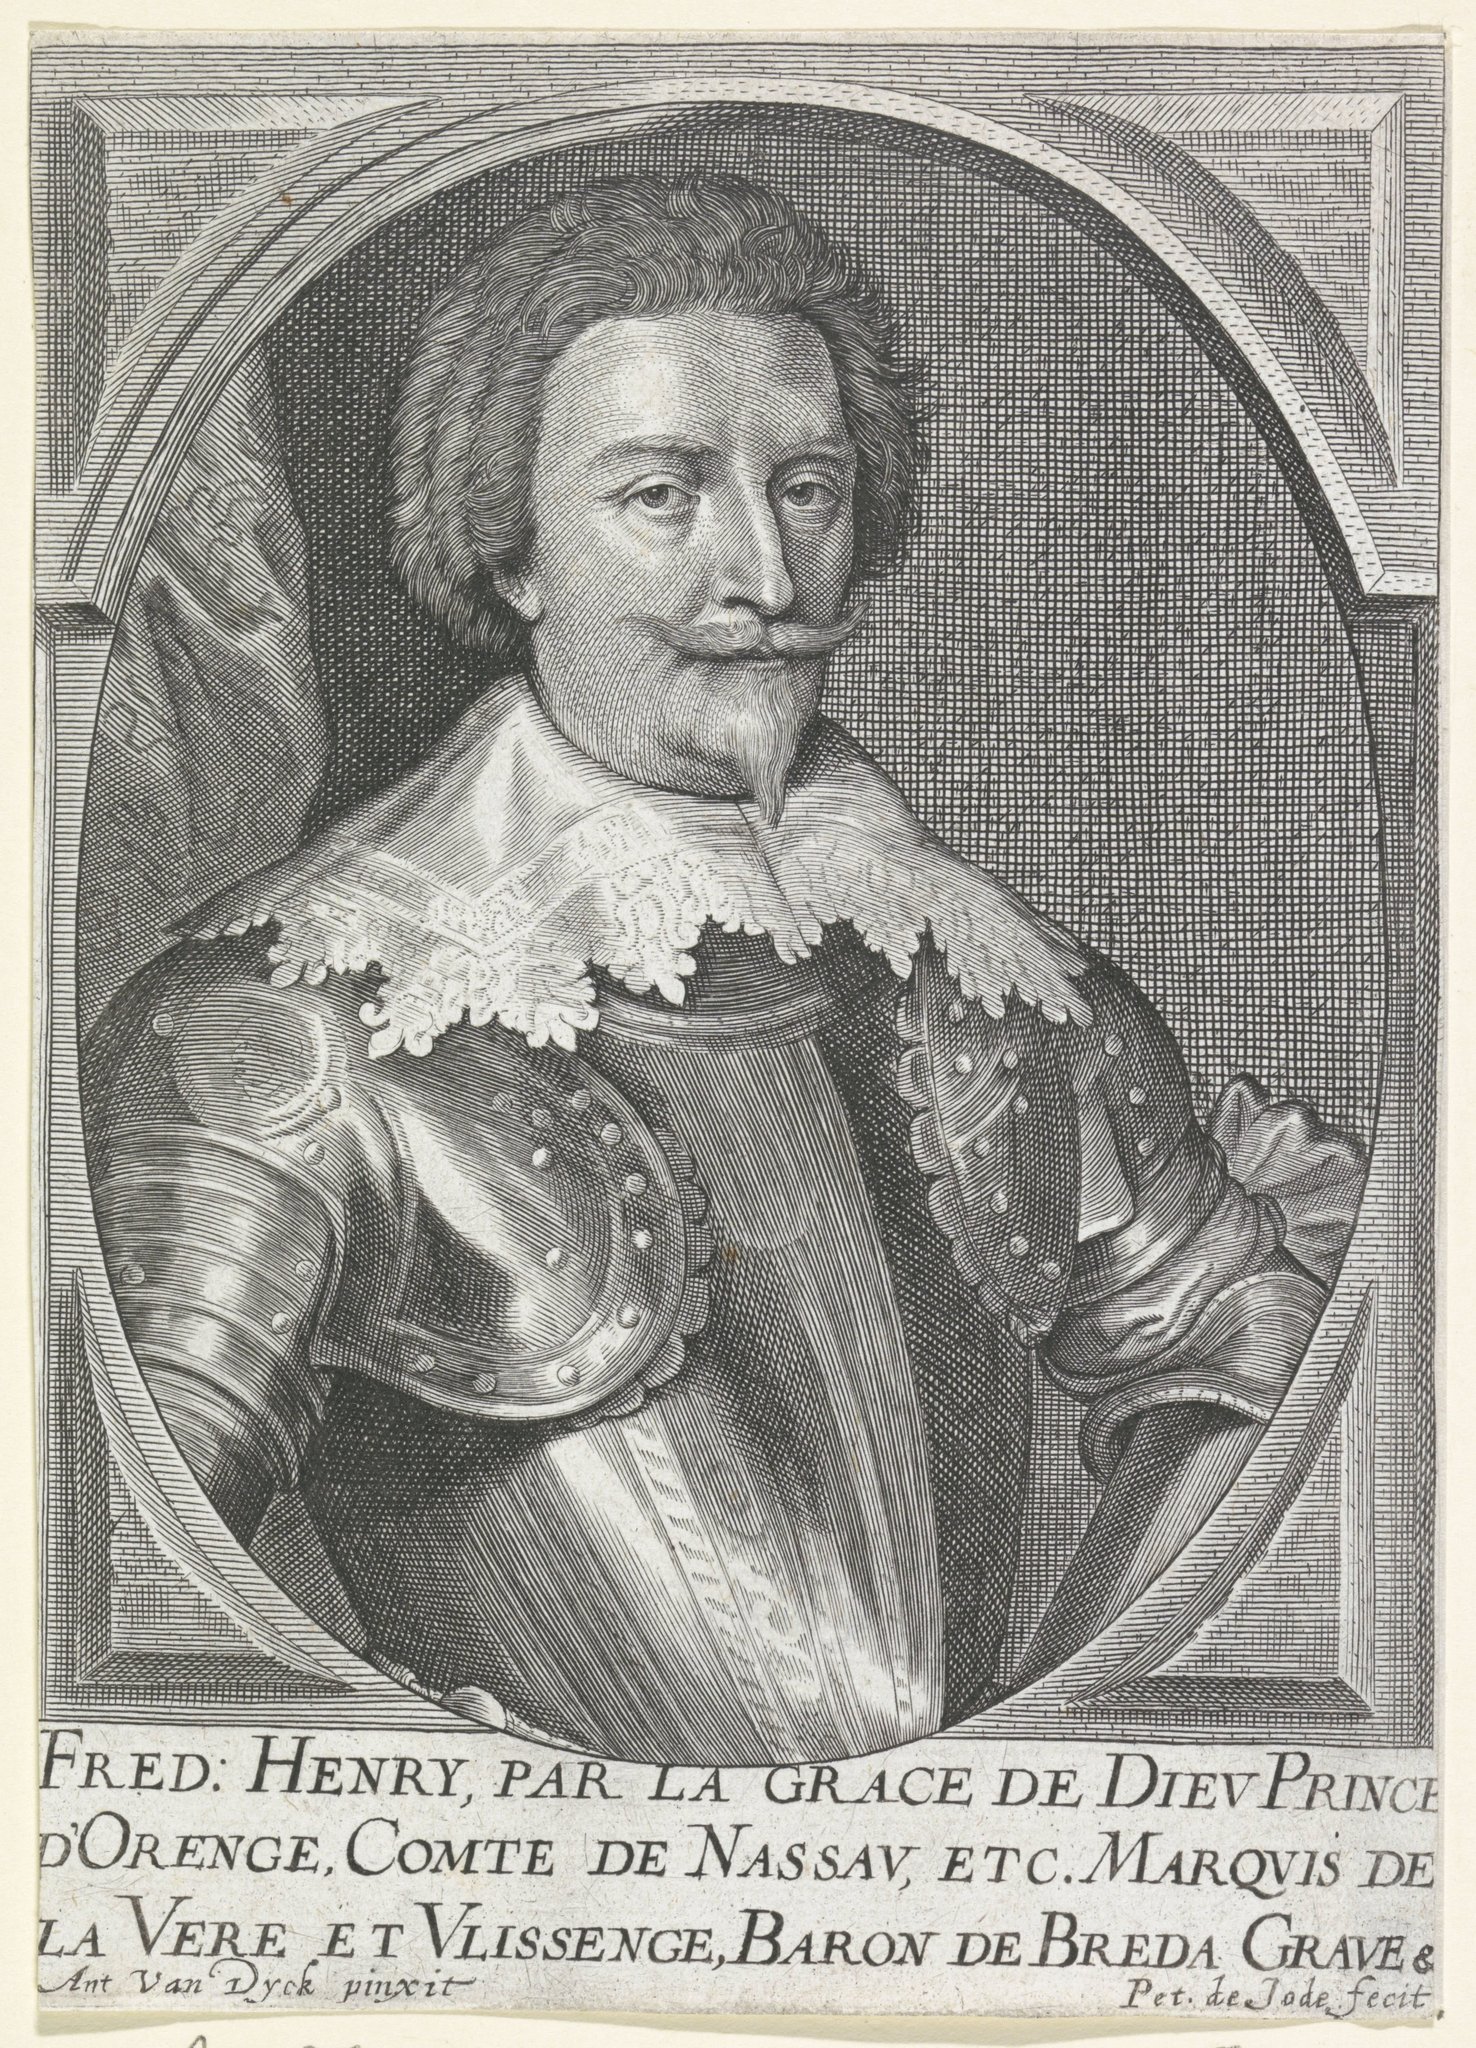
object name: print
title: Portret van Frederik Hendrik, prins van Oranje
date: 1628-1670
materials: paper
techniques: engraving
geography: antwerp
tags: delft, the hague, frederick henry (prince of orange)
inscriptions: collector's mark: Lugt 2228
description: De hier vermelde titel verwijst naar de hoogst verkregen titel van de geportretteerde, niet per se naar de titel die de geportretteerde op deze voorstelling draagt.